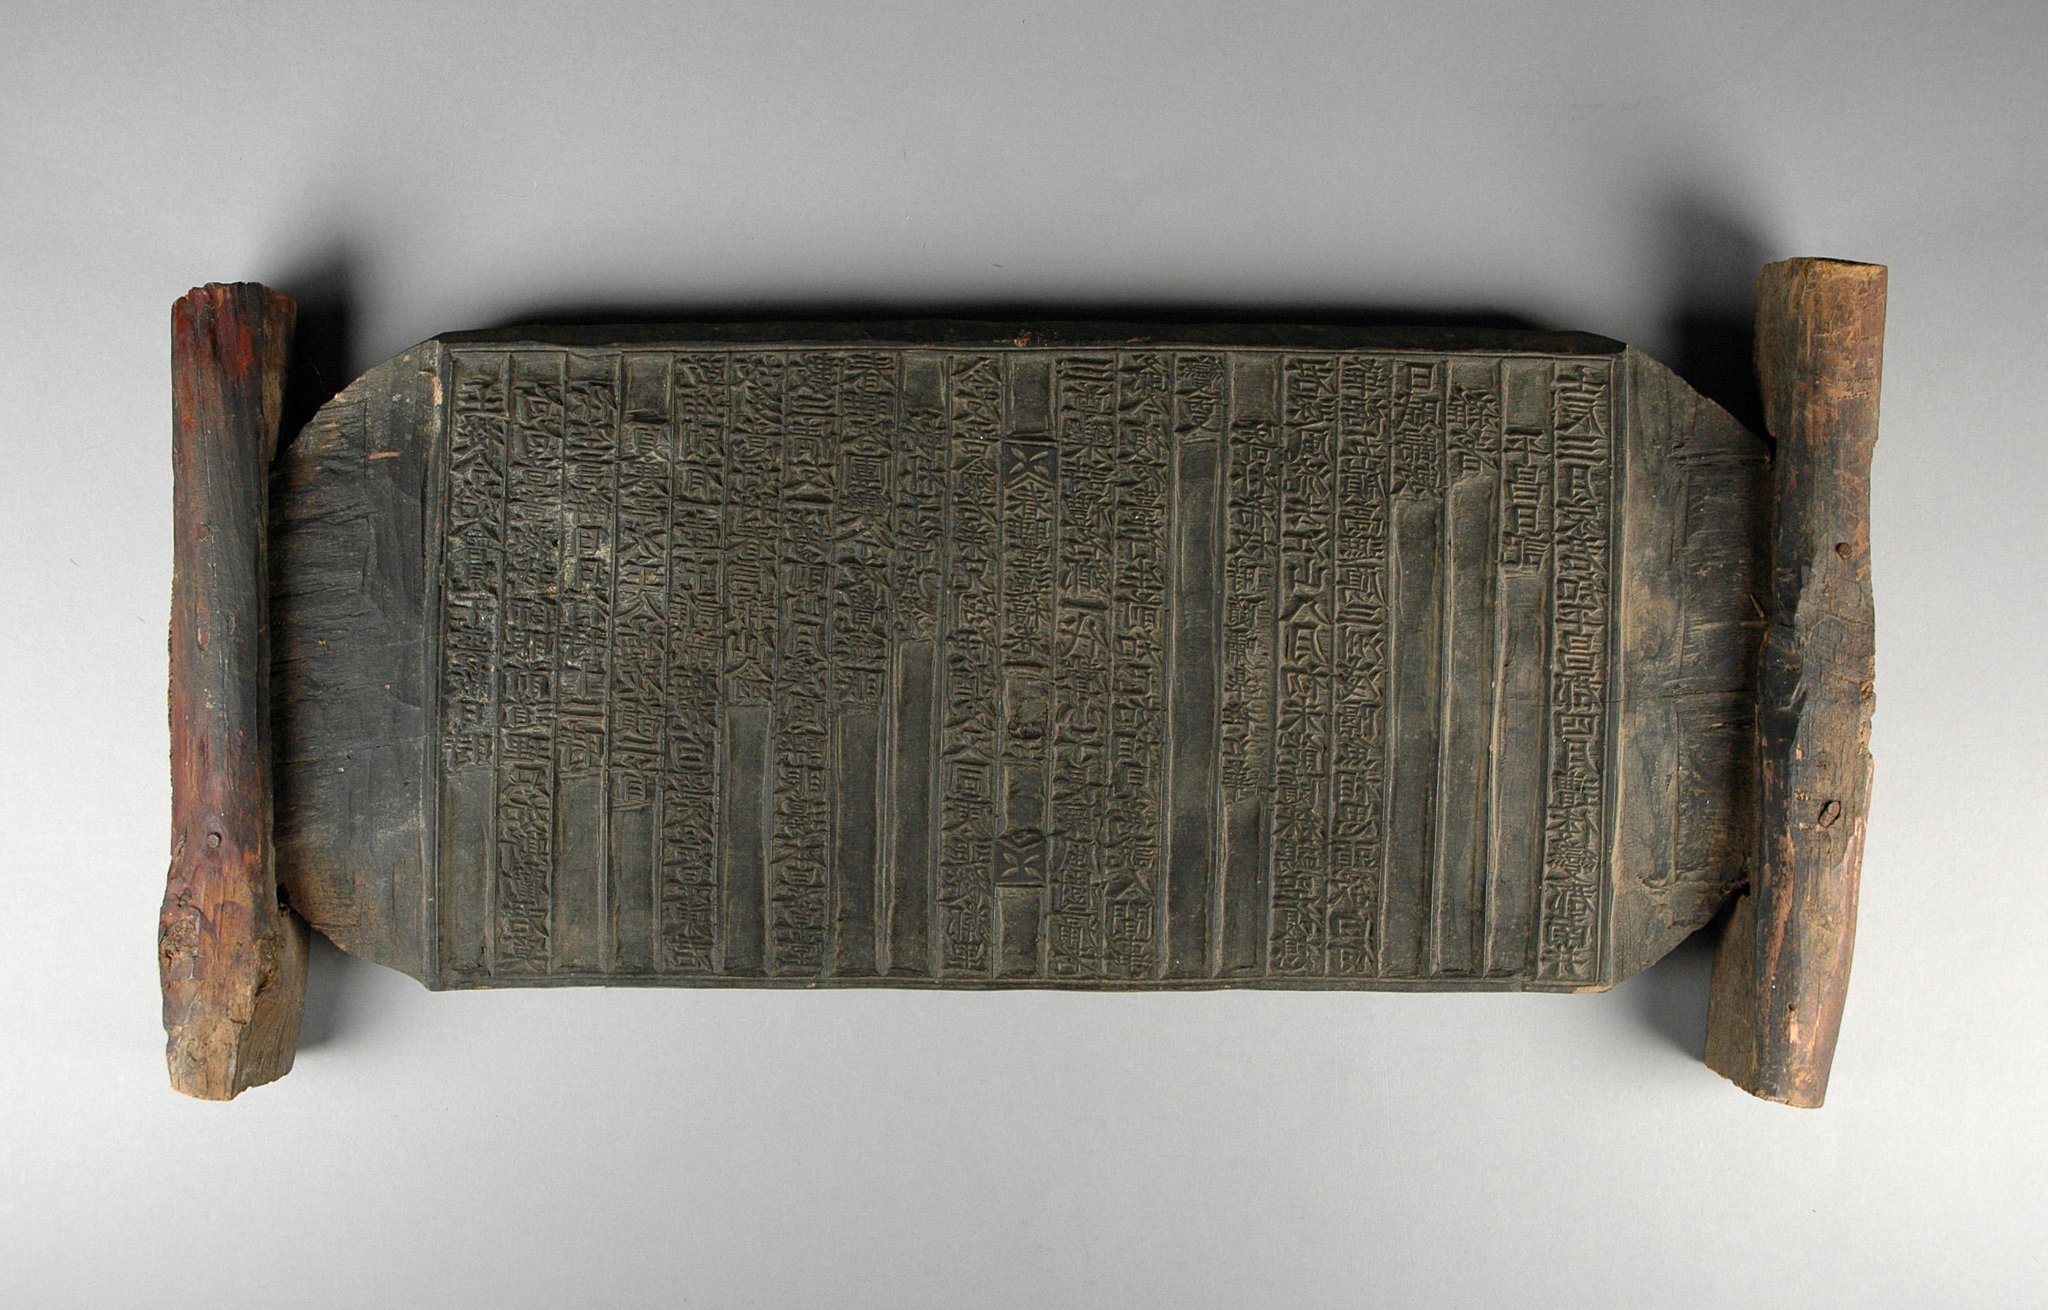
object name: woodblock printing block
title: Woodblock of Collected Poems of the House of Springtime Sleep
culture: korean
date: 1801-1900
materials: wood